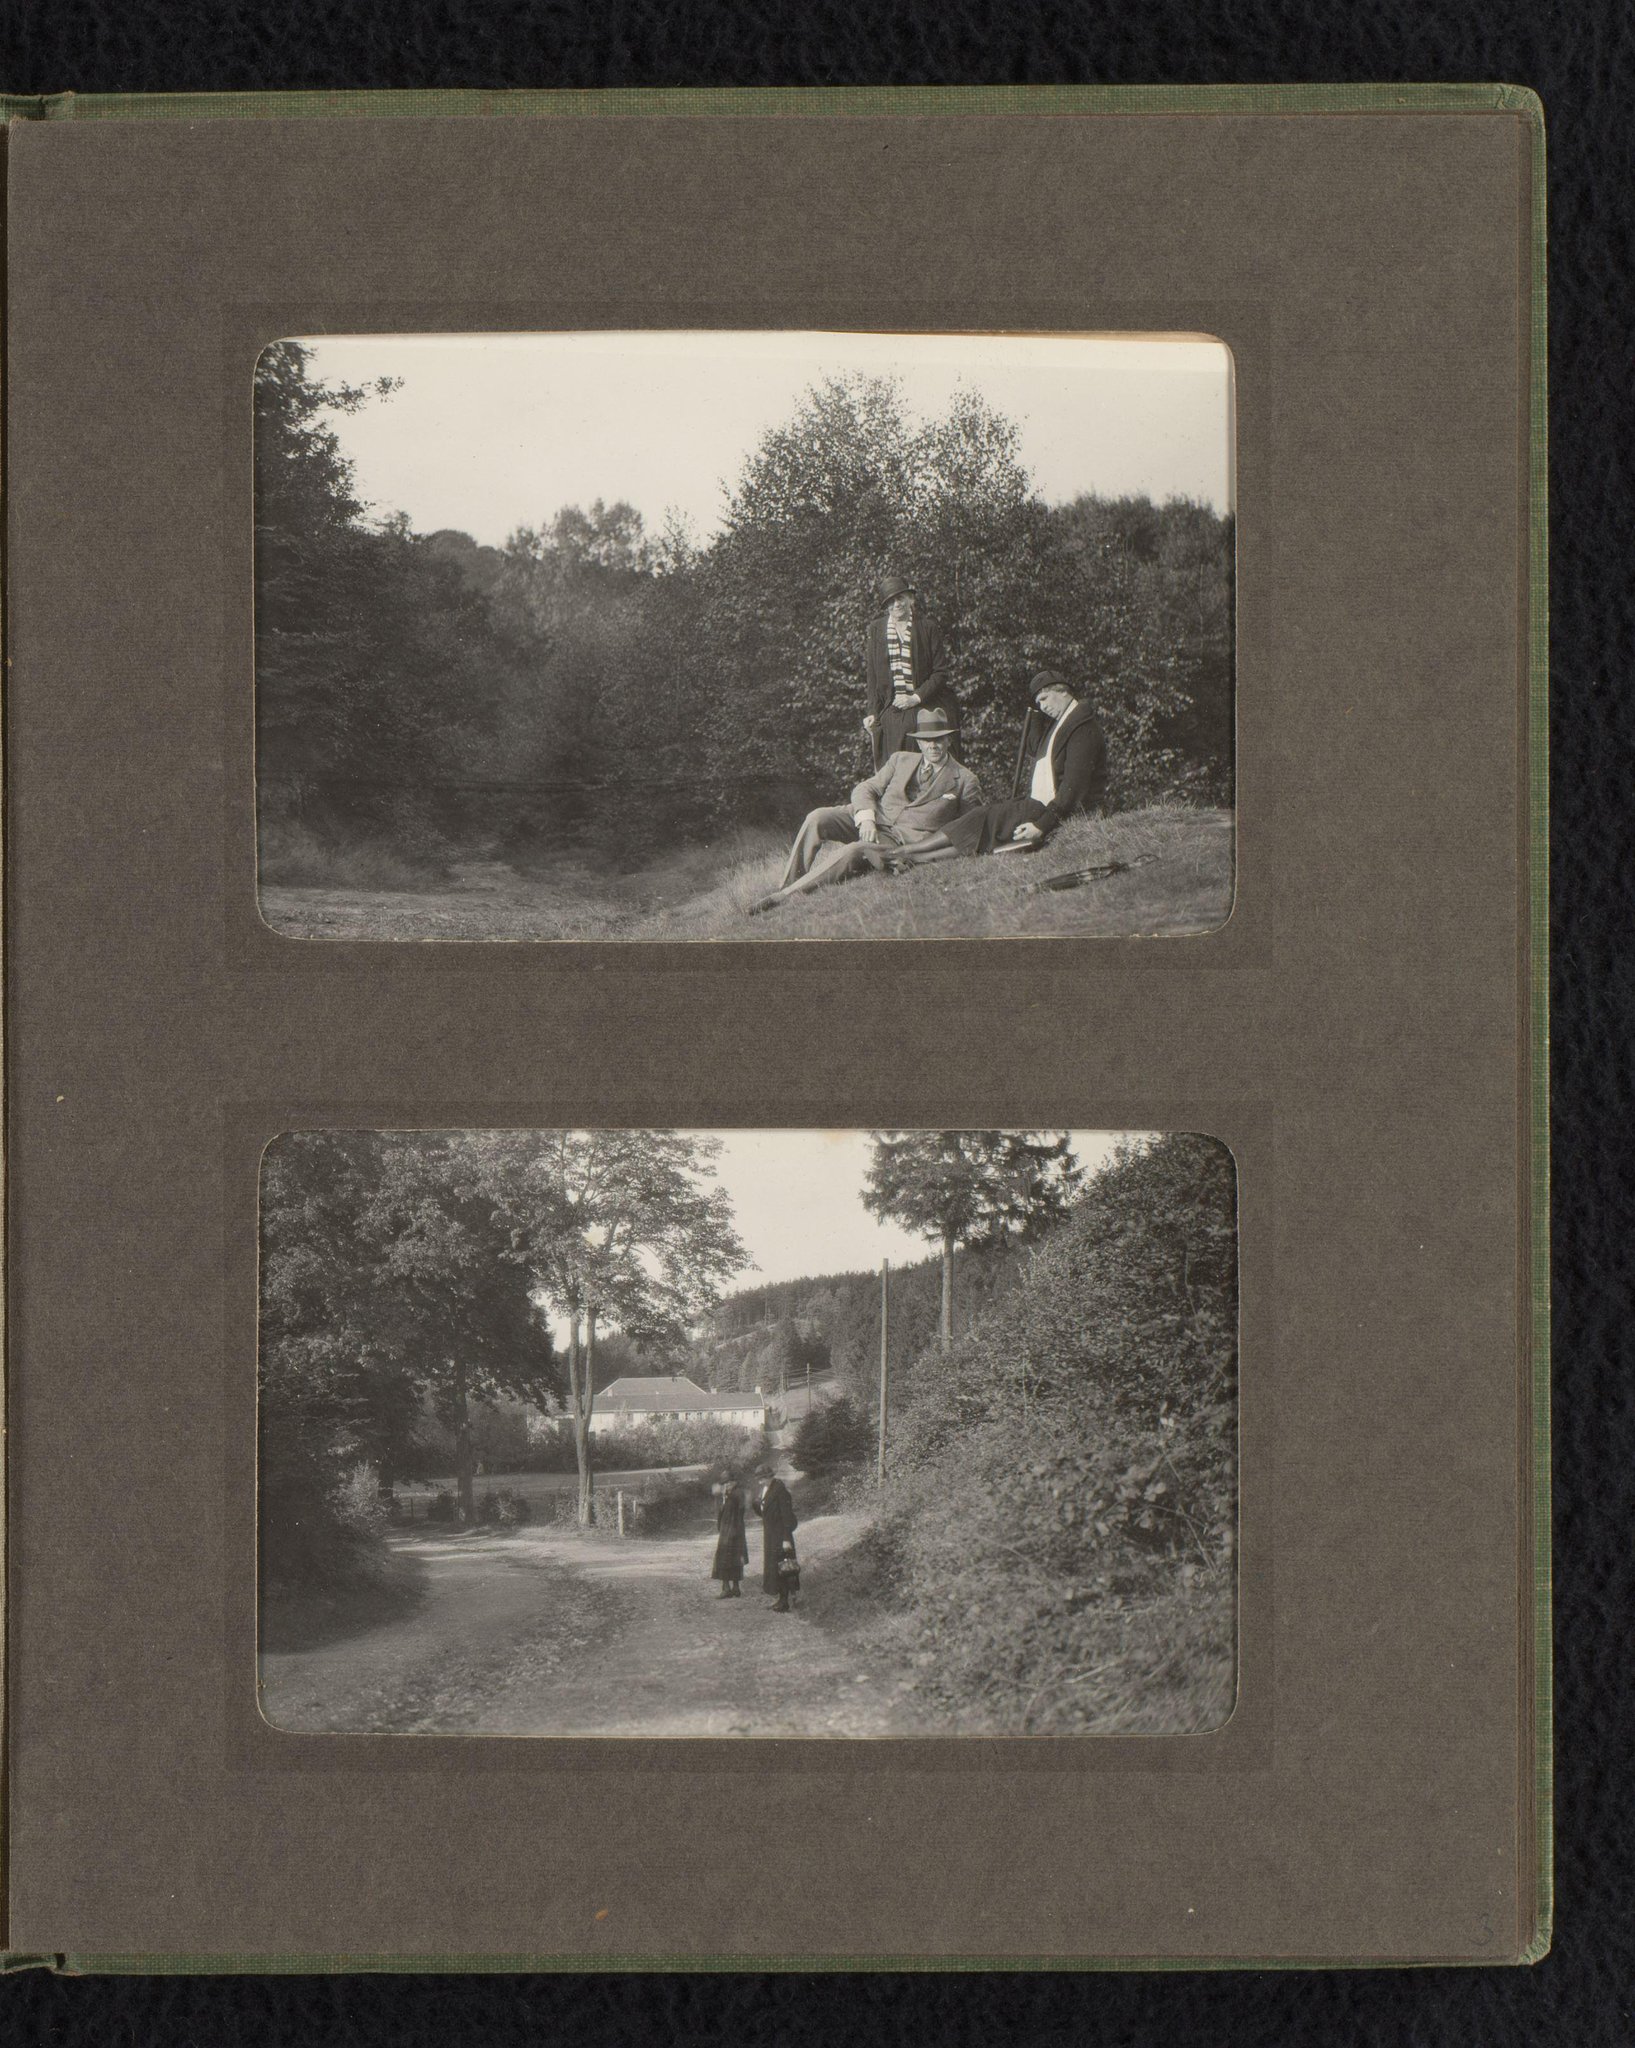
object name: album leaf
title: Twee foto's familie Van den Berg tijdens een wandeling in Duitsland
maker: frank willem van den berg (1912-1998)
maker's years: 1912-1998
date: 1932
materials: paper, cardboard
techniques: gelatin silver print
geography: germany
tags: batavia, amsterdam, hendrik herman van den berg, the hague, caroline louise van den berg-van den berg, walking, hiking (recreation), historical persons, germany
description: Deze foto's maken deel uit van een album.